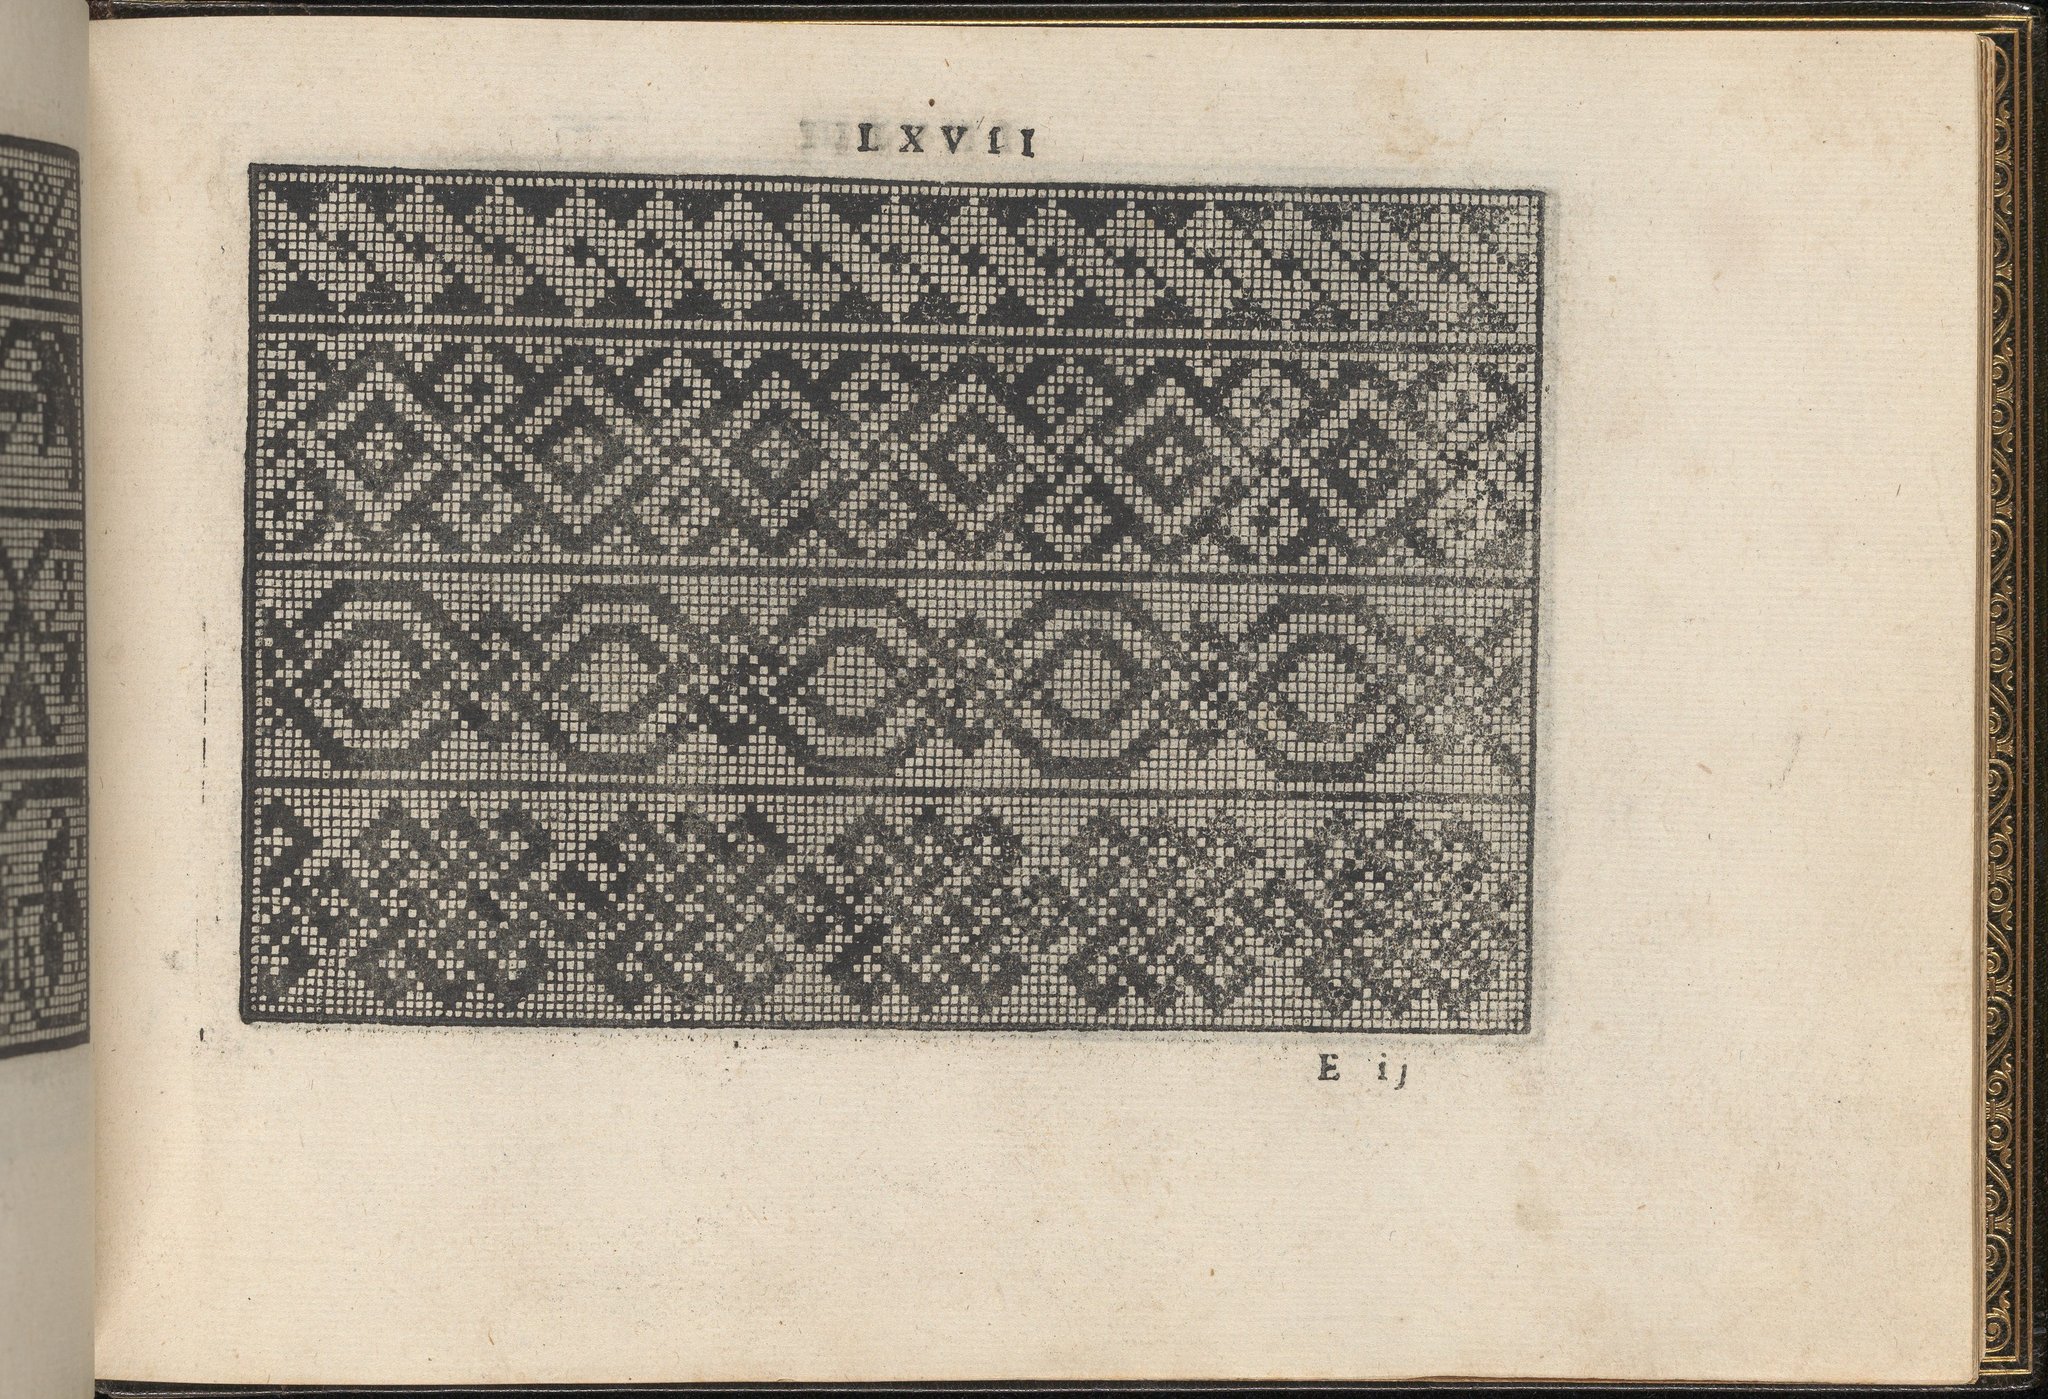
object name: book print ornament architecture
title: La Vera Perfettione del Disegno di varie sorti di recami, page 34 (recto)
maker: giovanni ostaus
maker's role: publisher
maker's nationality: italian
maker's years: 1507-1607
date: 1567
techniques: woodcut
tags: ornament